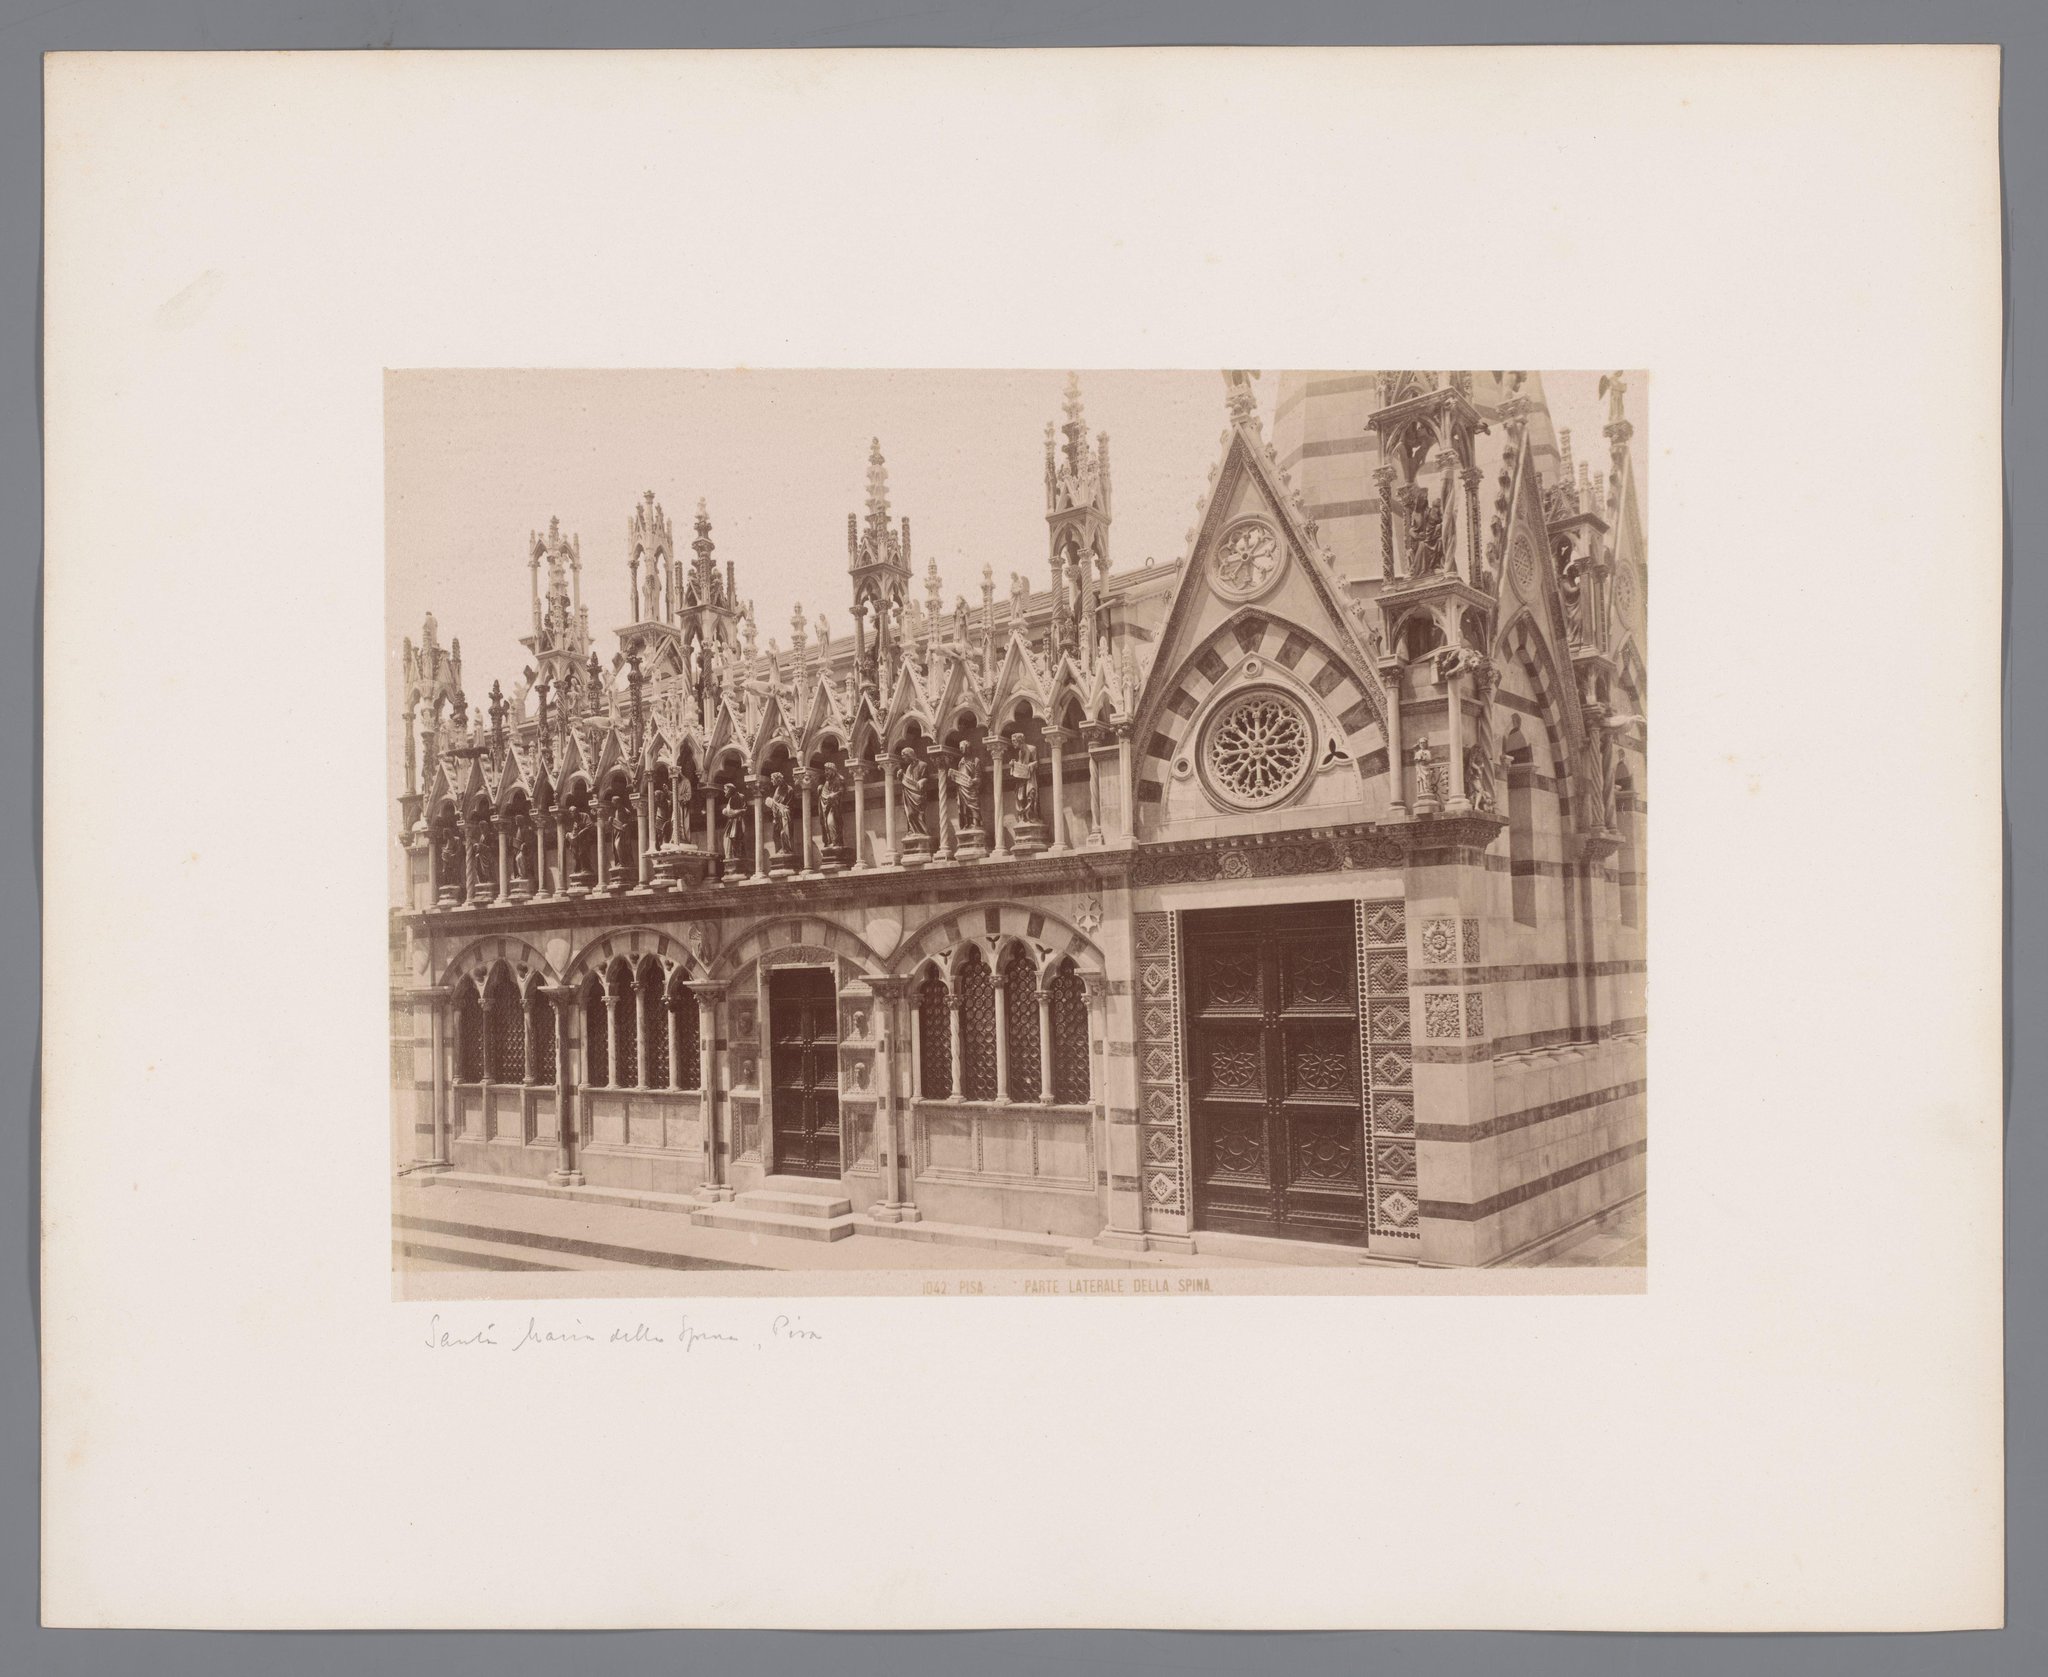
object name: photograph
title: Pisa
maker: Anonymous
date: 1851-1900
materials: cardboard, paper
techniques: albumen print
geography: pisa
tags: church (exterior)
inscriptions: number: ‘1042.’, inscription: ‘Santa Maria della SPina, Pisa’